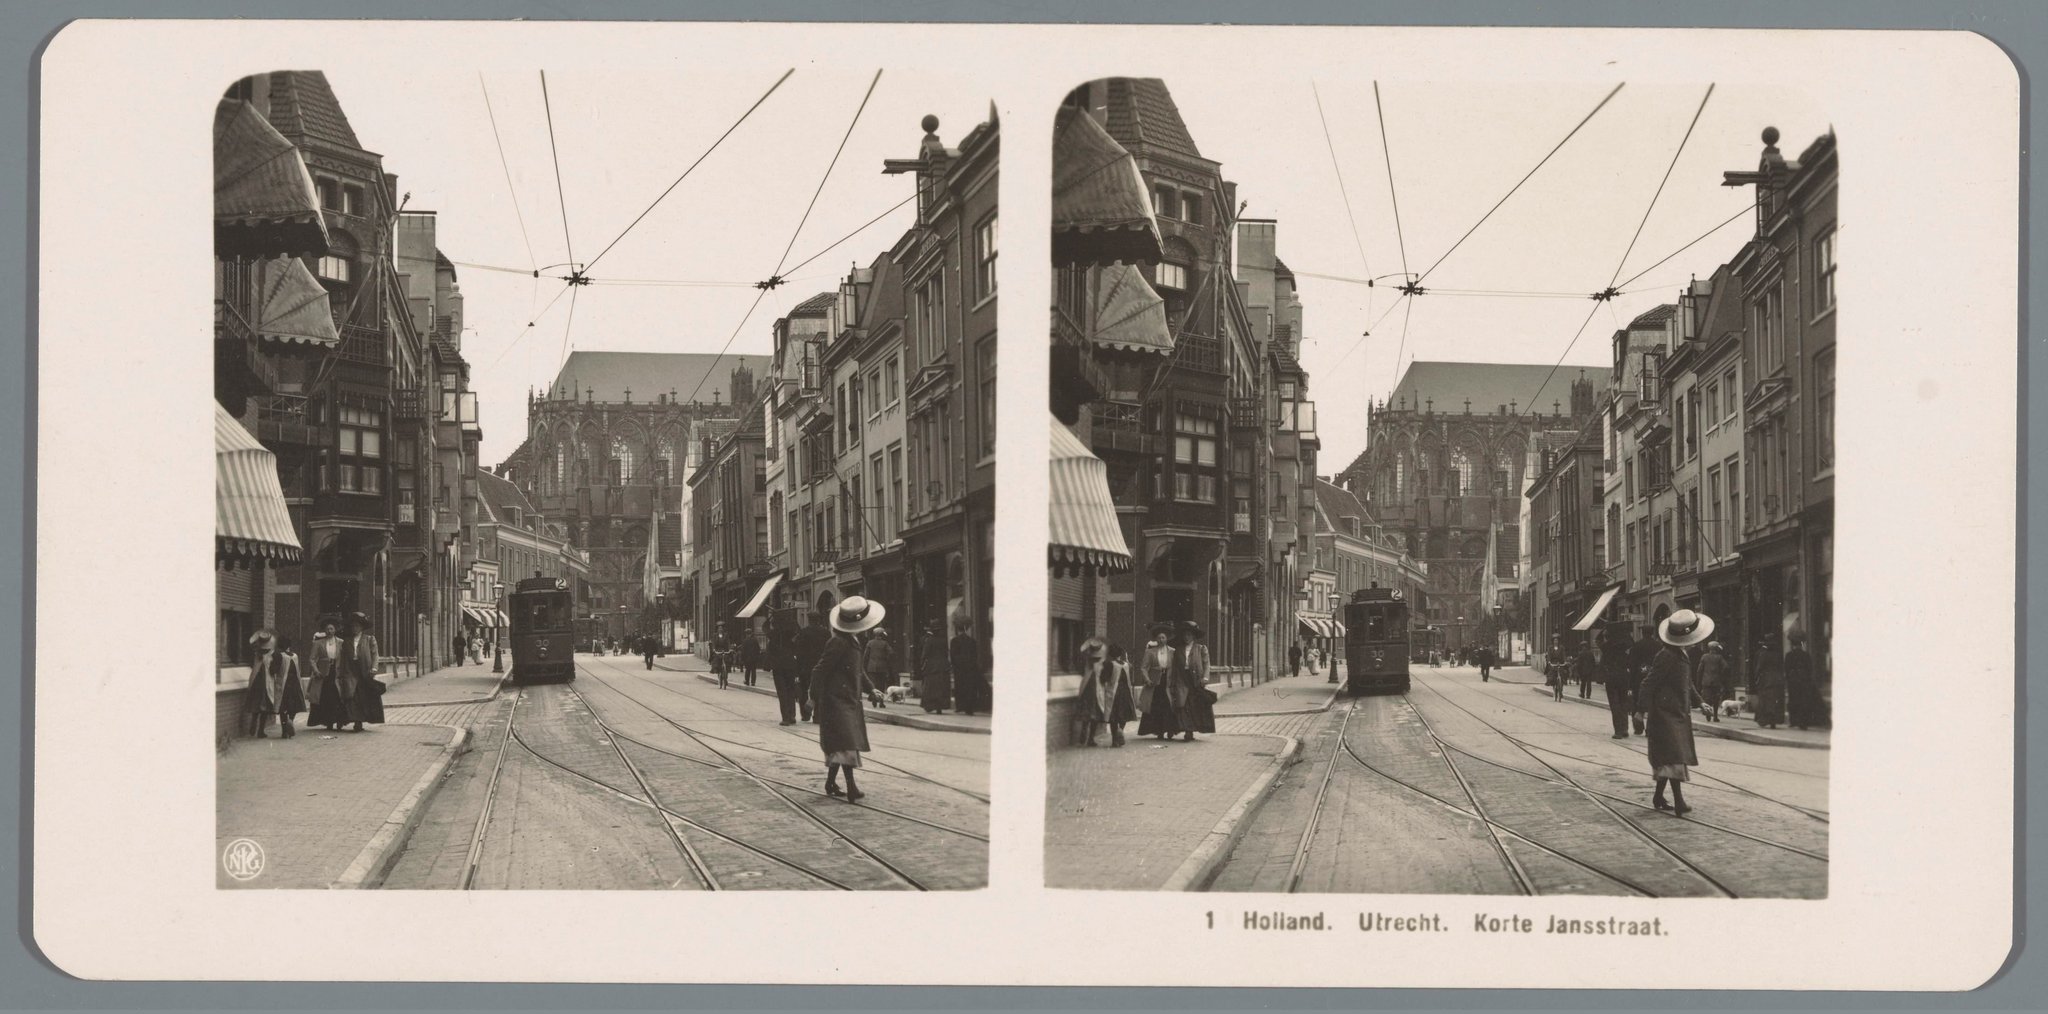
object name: stereograph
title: Holland. Utrecht. Korte Jansstraat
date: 1900-1910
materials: cardboard, photographic support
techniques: gelatin silver print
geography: utrecht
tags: tramway, tram, street, utrecht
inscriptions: inscription: ‘NPG’, number: ‘1’